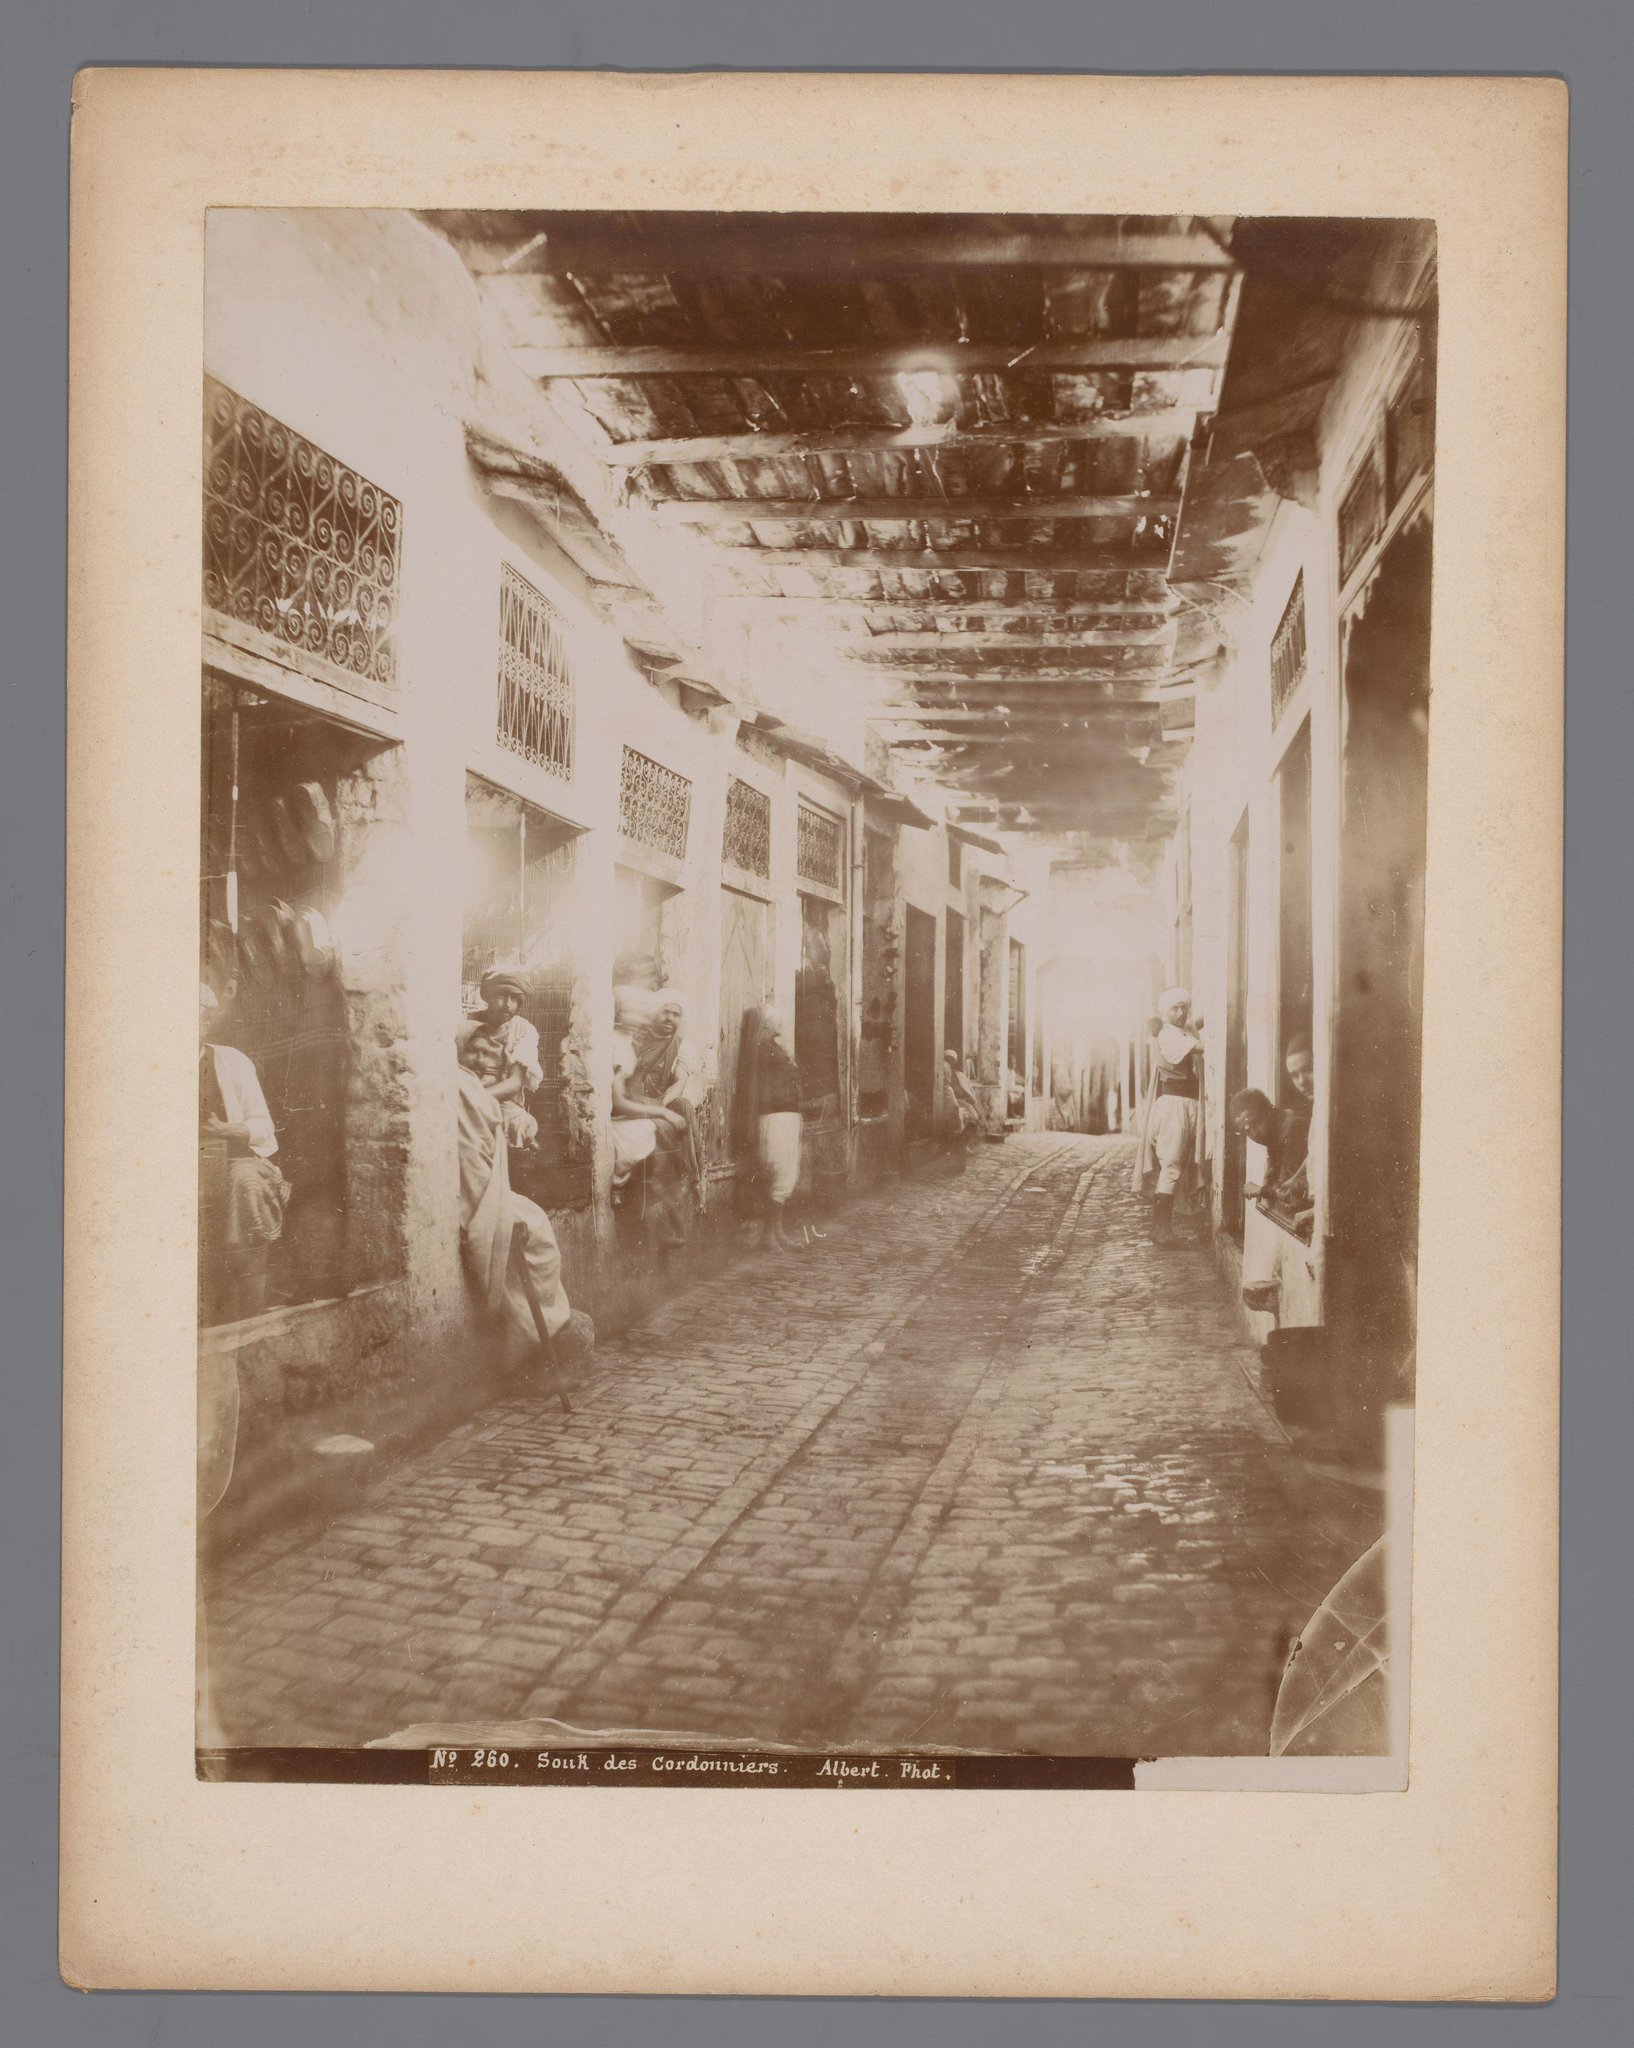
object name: photograph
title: Schoenmakers in een soek, vermoedelijk in het Medina van Tunis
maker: albert goupil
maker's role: publisher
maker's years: 1840-1884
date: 1860-1900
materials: cardboard, paper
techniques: albumen print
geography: medina of tunis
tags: shoe-maker, cobbler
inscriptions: number: ‘No 260.’